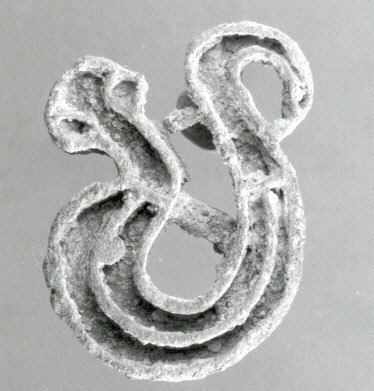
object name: stamp seal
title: Compartmented stamp seal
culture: bactria-margiana archaeological complex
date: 2333-1668 BCE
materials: copper alloy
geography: bactria-margiana